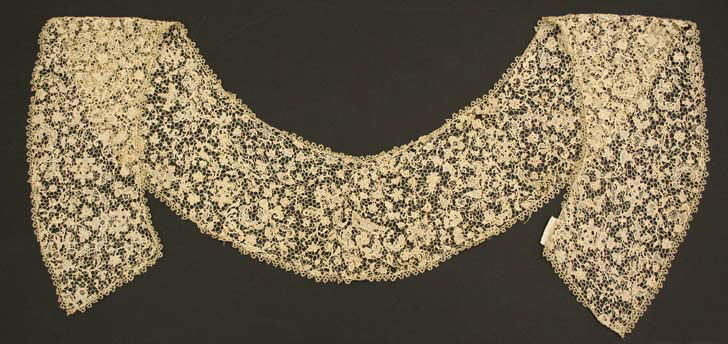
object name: bertha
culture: italian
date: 1601-1700